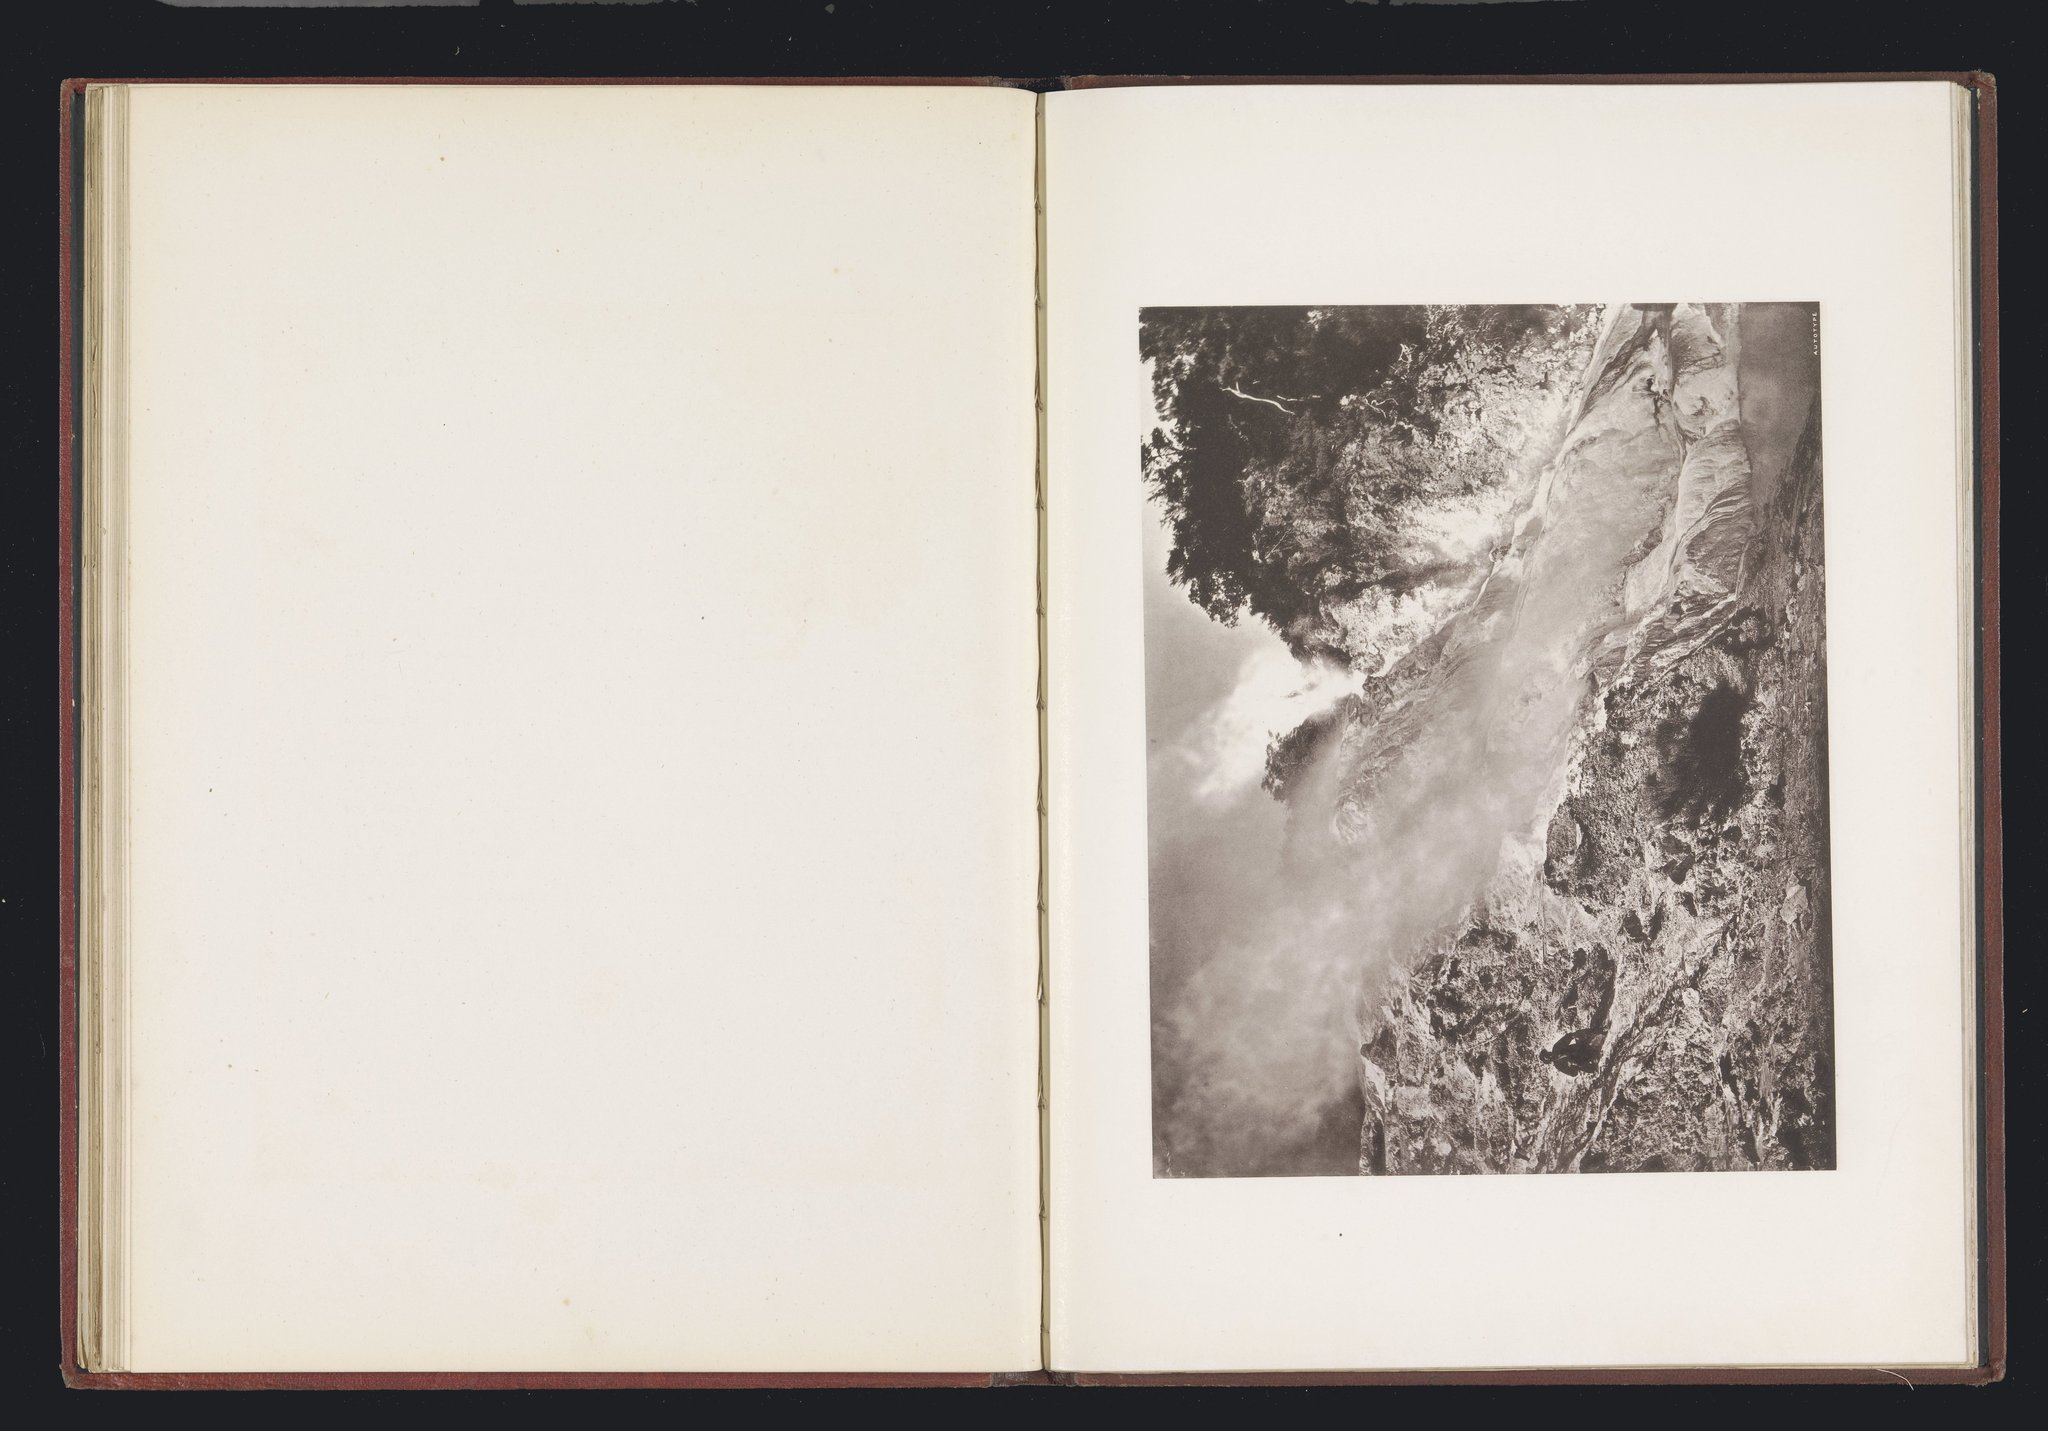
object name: page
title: Geiser nabij Lake Rotomahana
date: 1865-1875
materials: paper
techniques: photograph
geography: new zealand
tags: steam, hot spring, geyser, lake